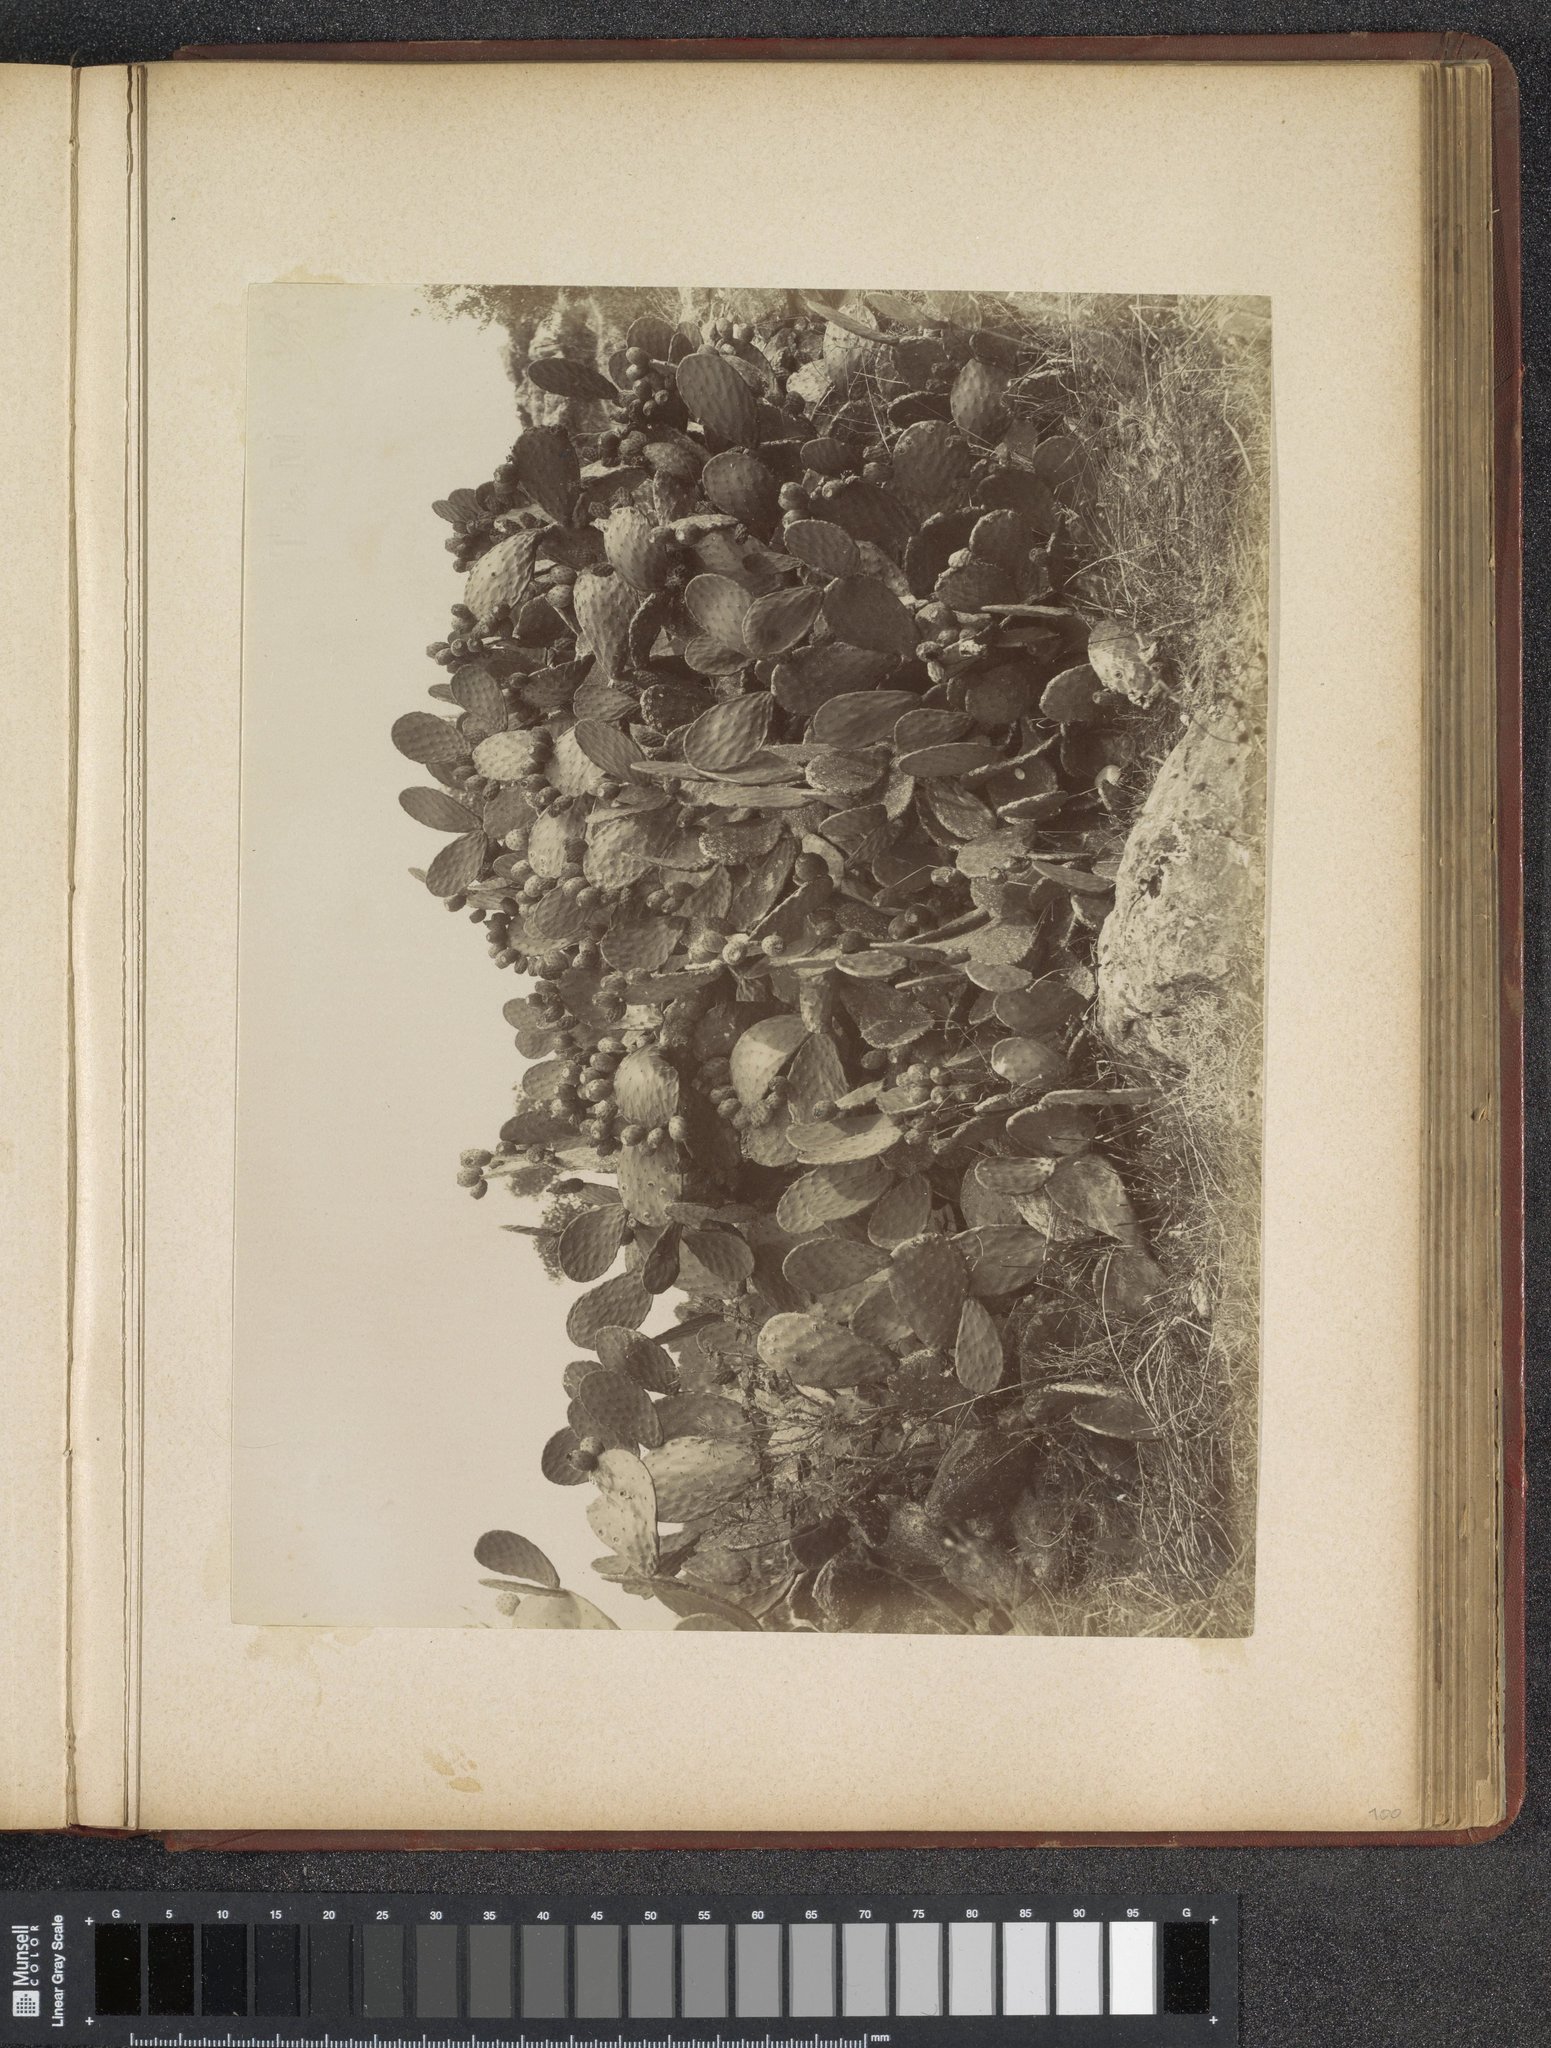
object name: album leaf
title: Cactussen, vermoedelijk aan de kust bij Cannes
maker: Anonymous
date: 1870-1900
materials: paper, photographic support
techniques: albumen print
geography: cannes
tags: plants and herbs: cactus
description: Onderdeel van Reisalbum met foto's van bezienswaardigheden in Italië en Zuid-Frankrijk.